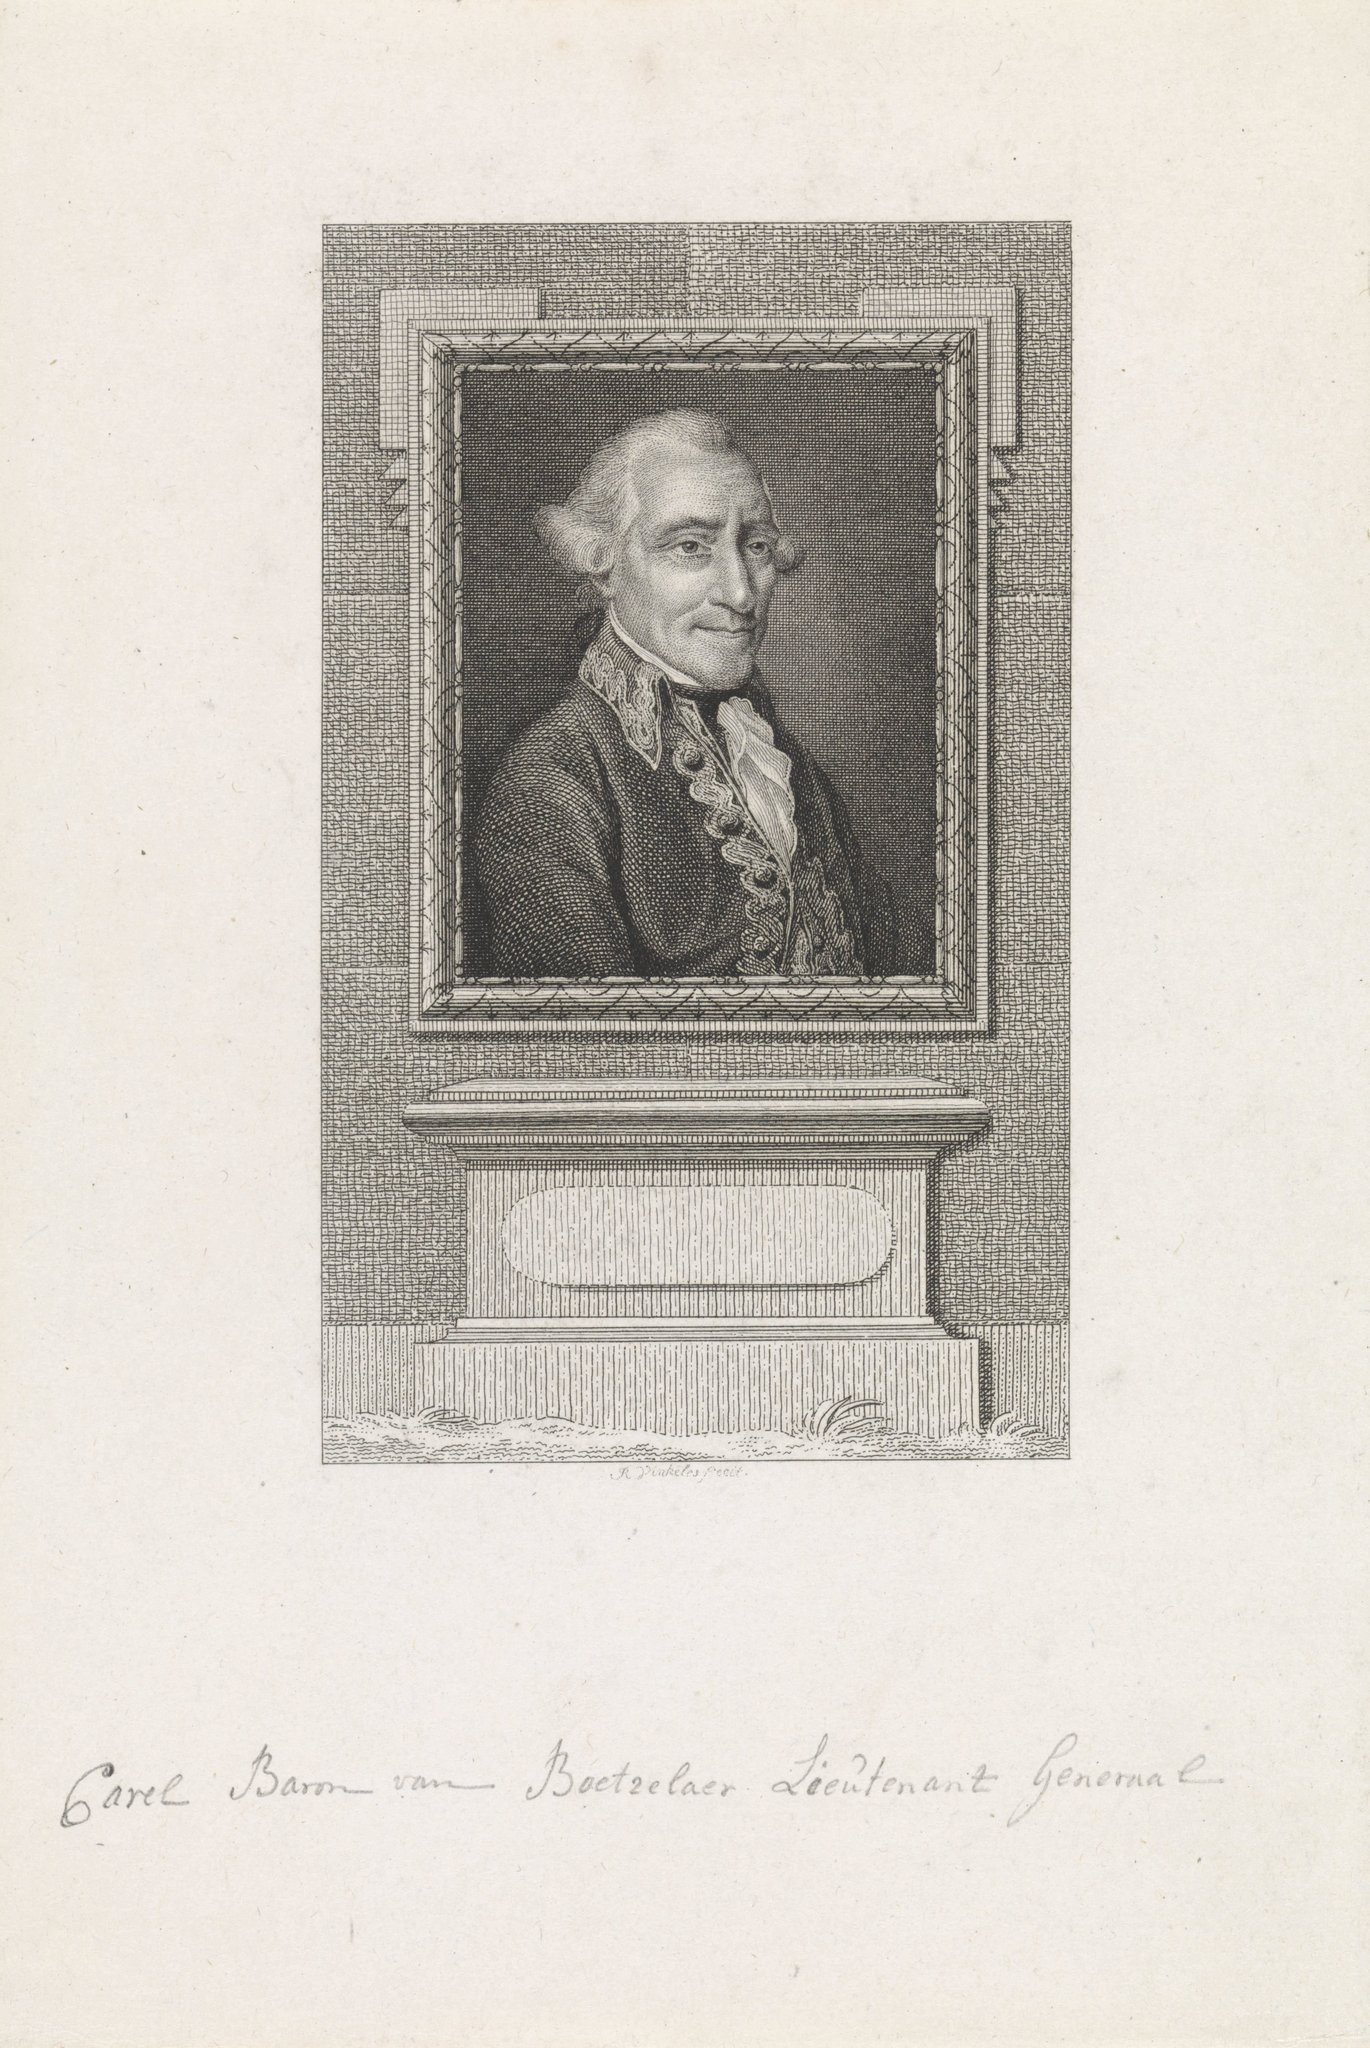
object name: print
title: Portret van Carel Baron van Boetzelaer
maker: reinier vinkeles (i)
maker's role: draughtsman, print maker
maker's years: 1741-1816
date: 1786-1809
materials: paper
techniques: engraving, etching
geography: amsterdam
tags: the hague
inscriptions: collector's mark: Lugt 240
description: Latere staat prent gebruikt in: Wagenaar, Jan. Vaderlandsche historie, (...) ten vervolge van Wagenaars Vaderlandsche historie. Dl. 1-43. Amsterdam: Johannes Allart, 1786-1809.